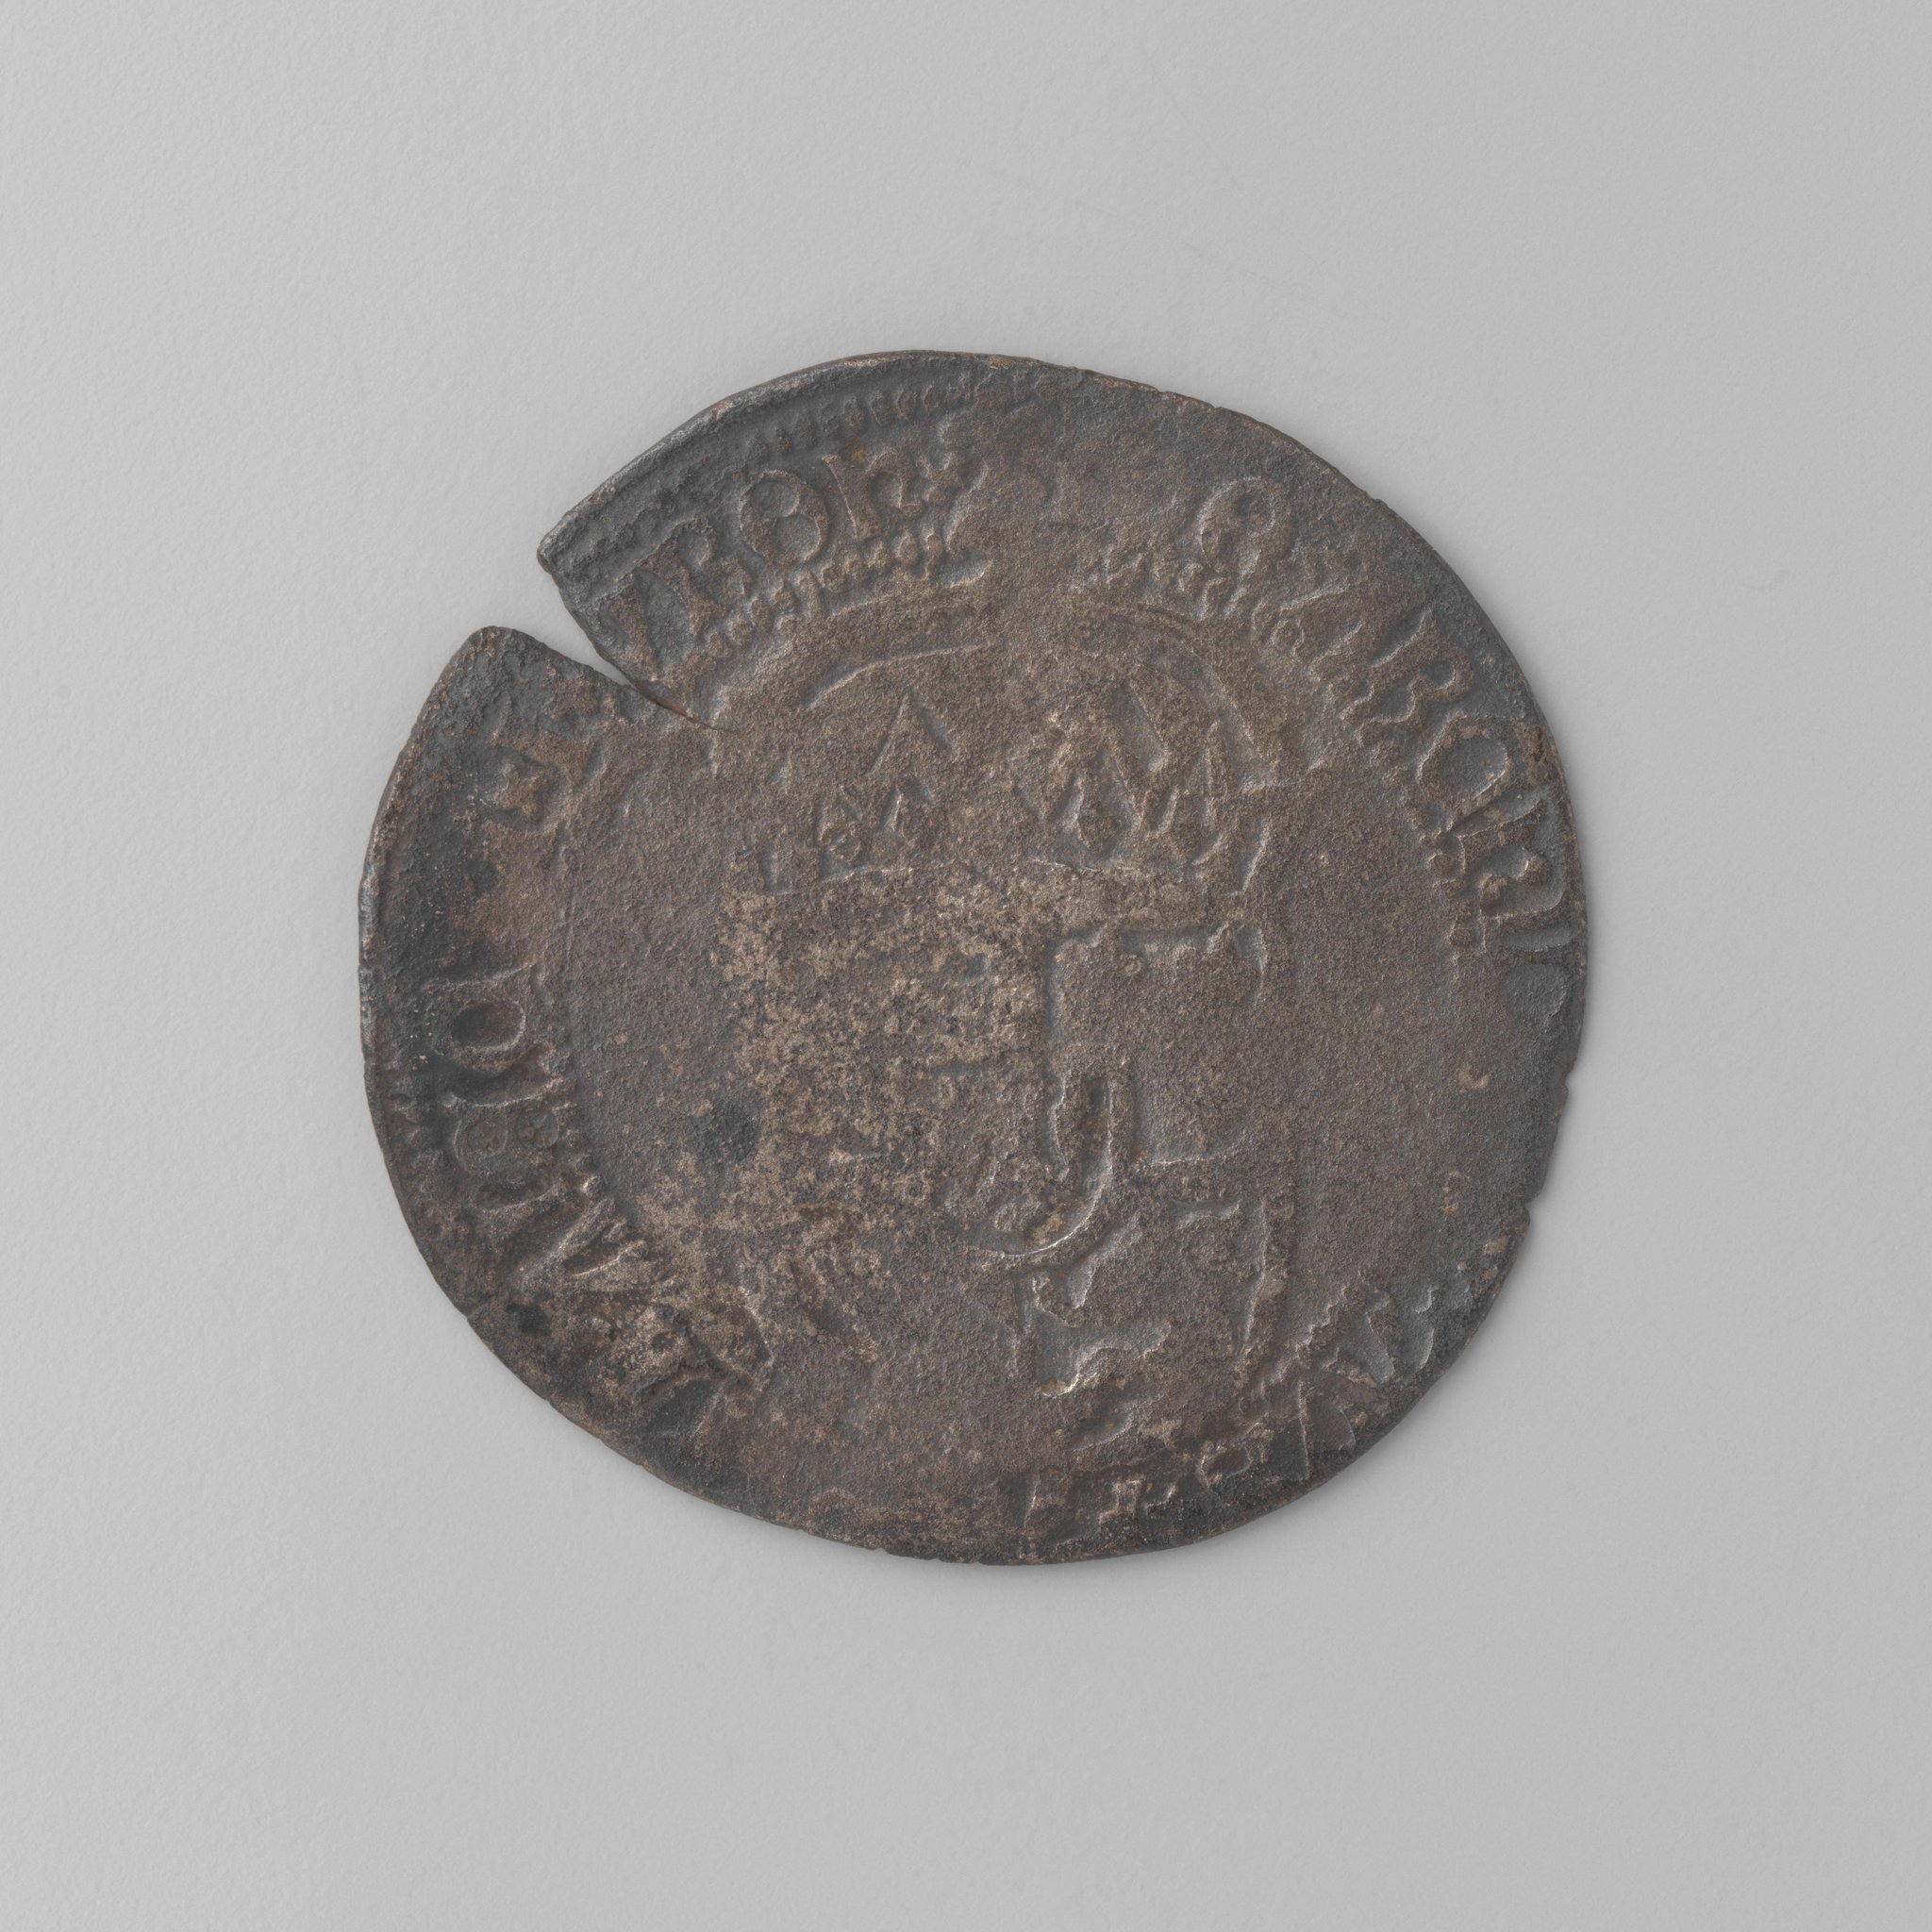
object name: coin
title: Keizer Karel V, hertog van Brabant, stuiver, 1512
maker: hertog van brabant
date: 1512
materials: silver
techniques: striking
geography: maastricht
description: Zilveren munt. Voorzijde: gekroond wapenschild. Keerzijde: op vierpas lang versierd kruis, in het hart ster.